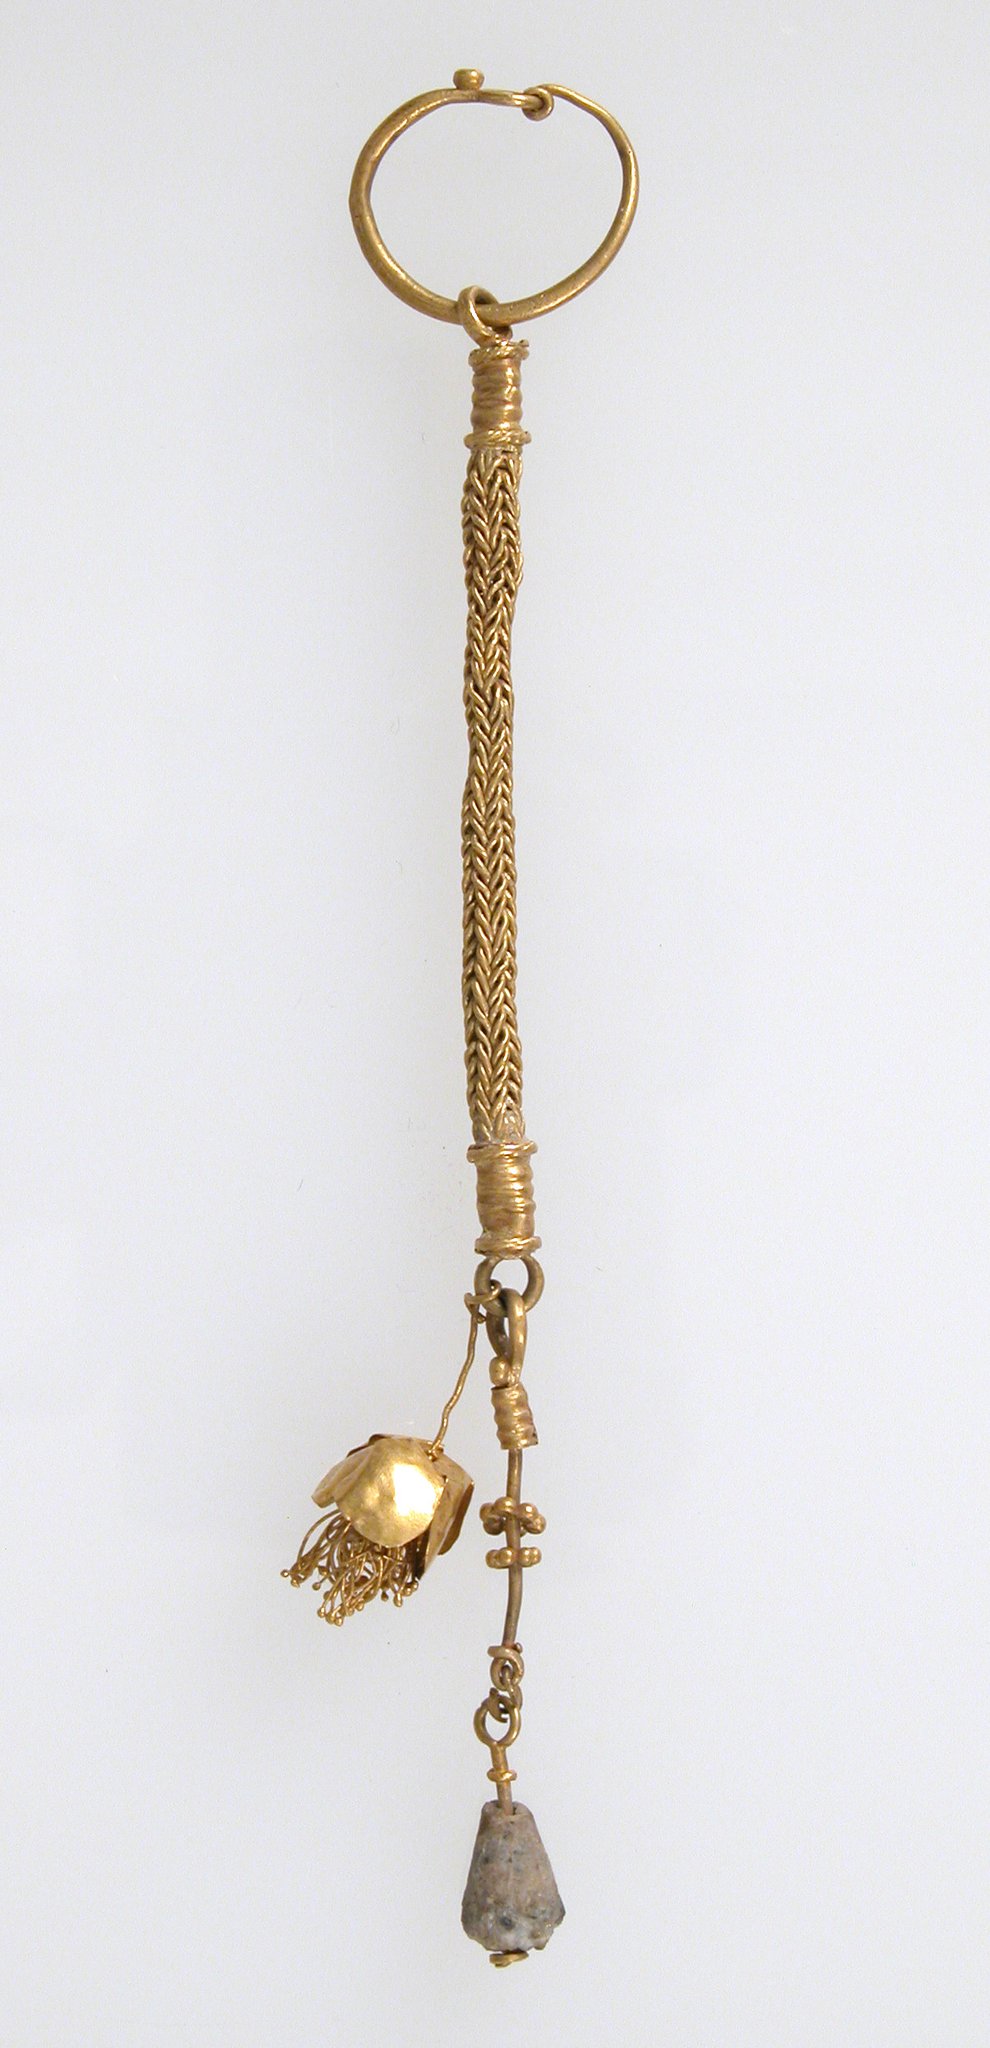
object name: earring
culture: east germanic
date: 201-300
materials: gold